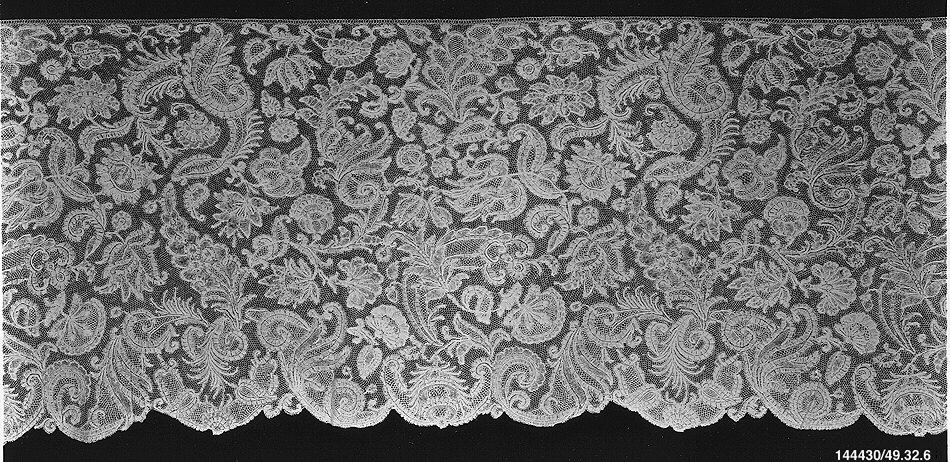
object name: flounce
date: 1726-1750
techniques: lace